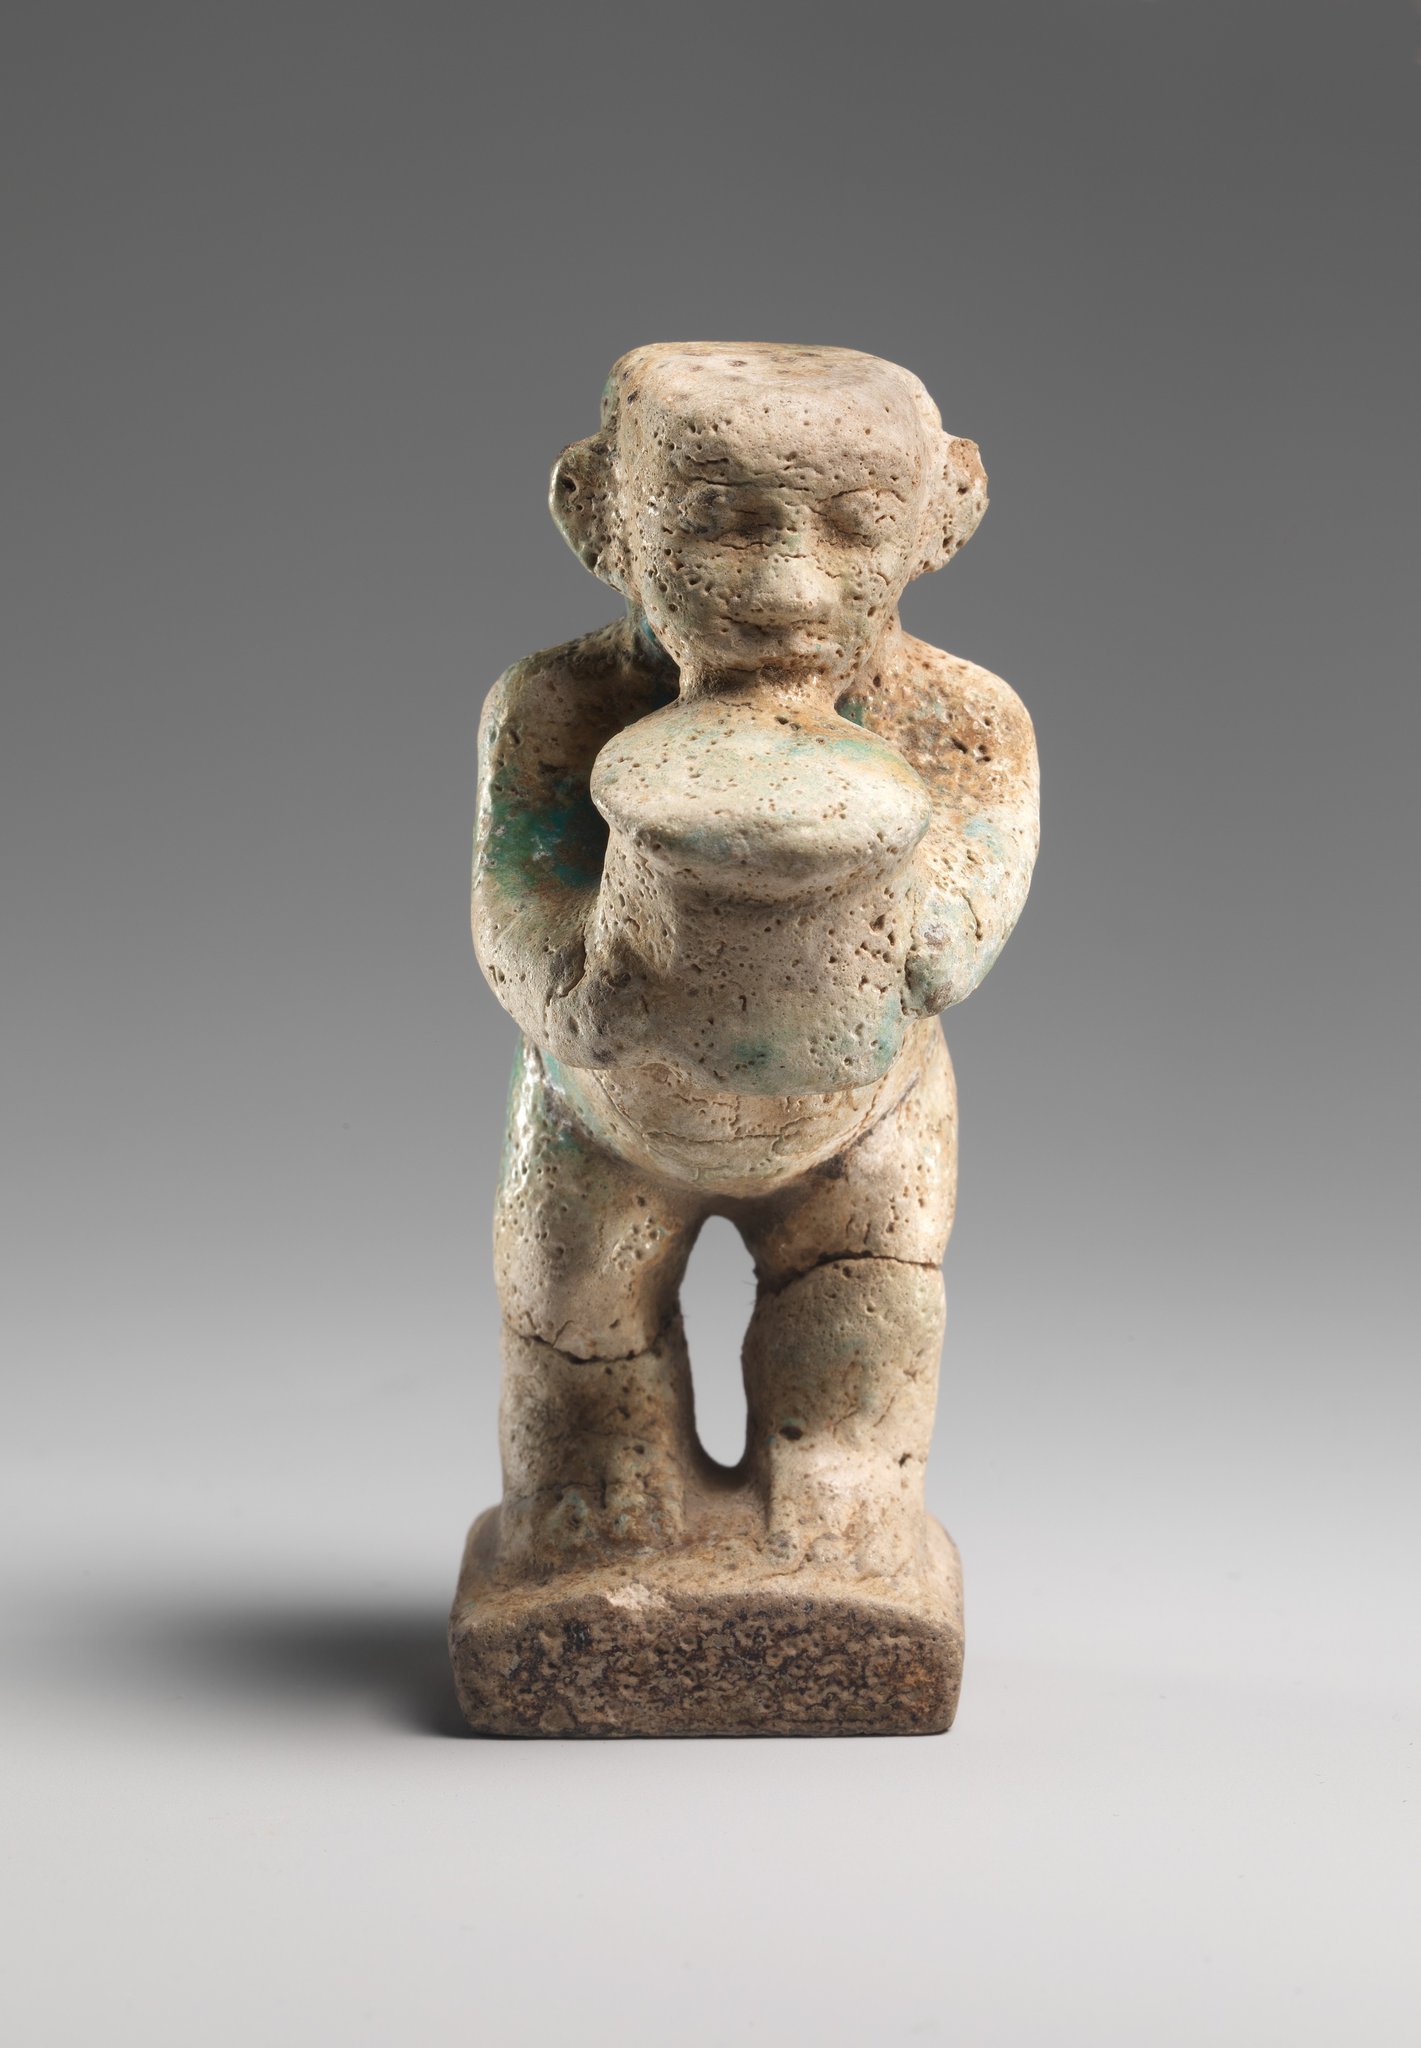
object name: statuette, dwarf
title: Figure of a dwarf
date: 1850-1750 BCE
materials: faience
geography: egypt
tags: men